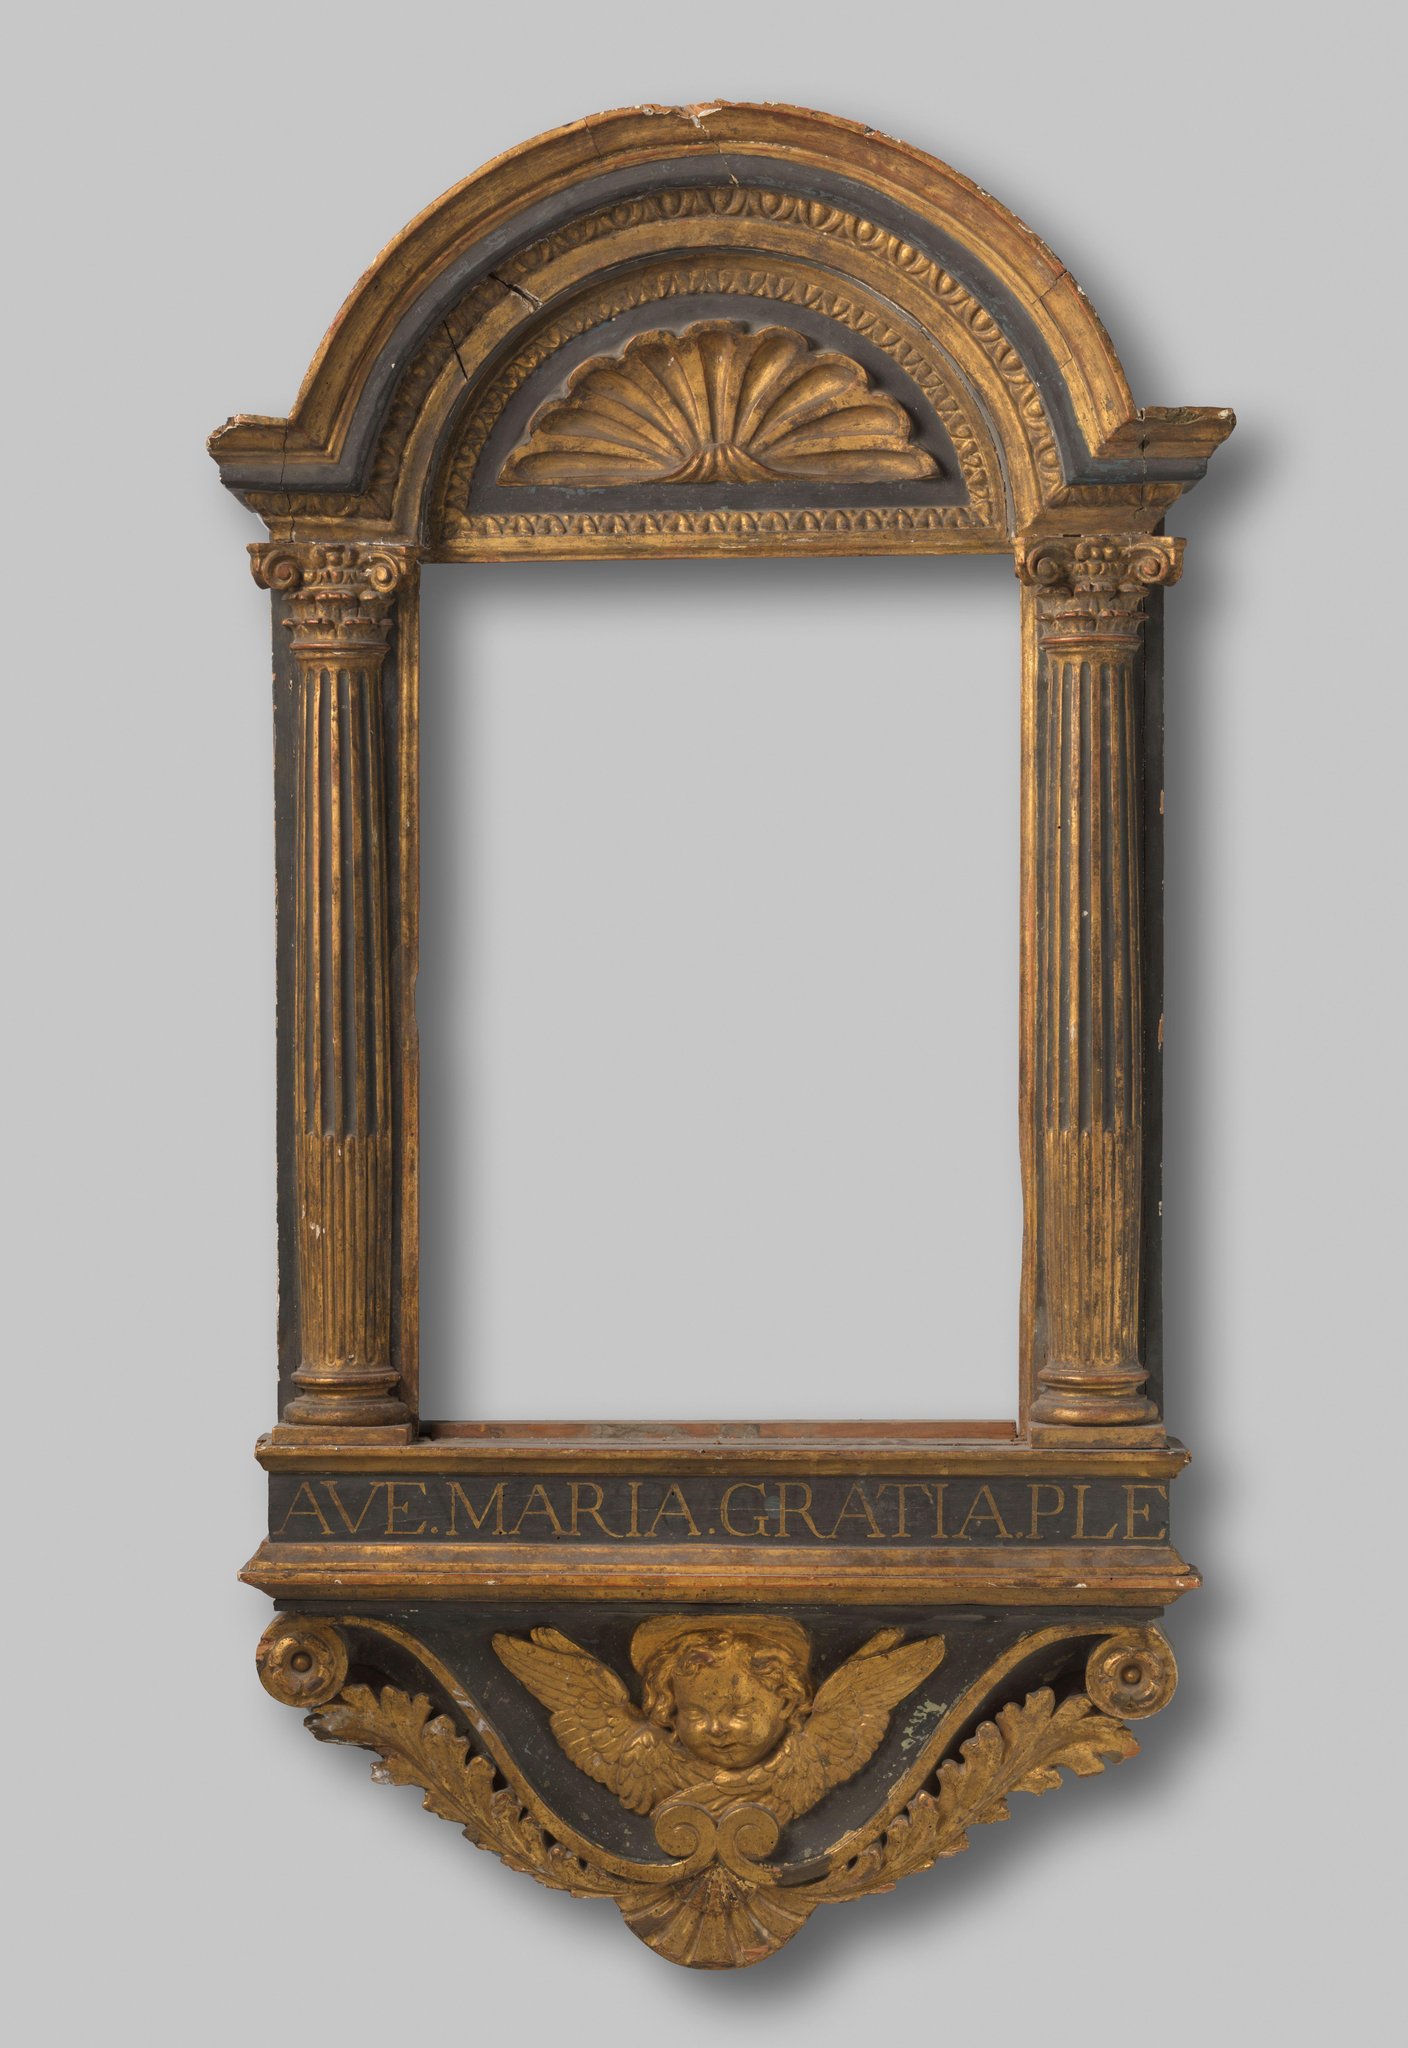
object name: frame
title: Lijst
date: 1450-1549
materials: wood